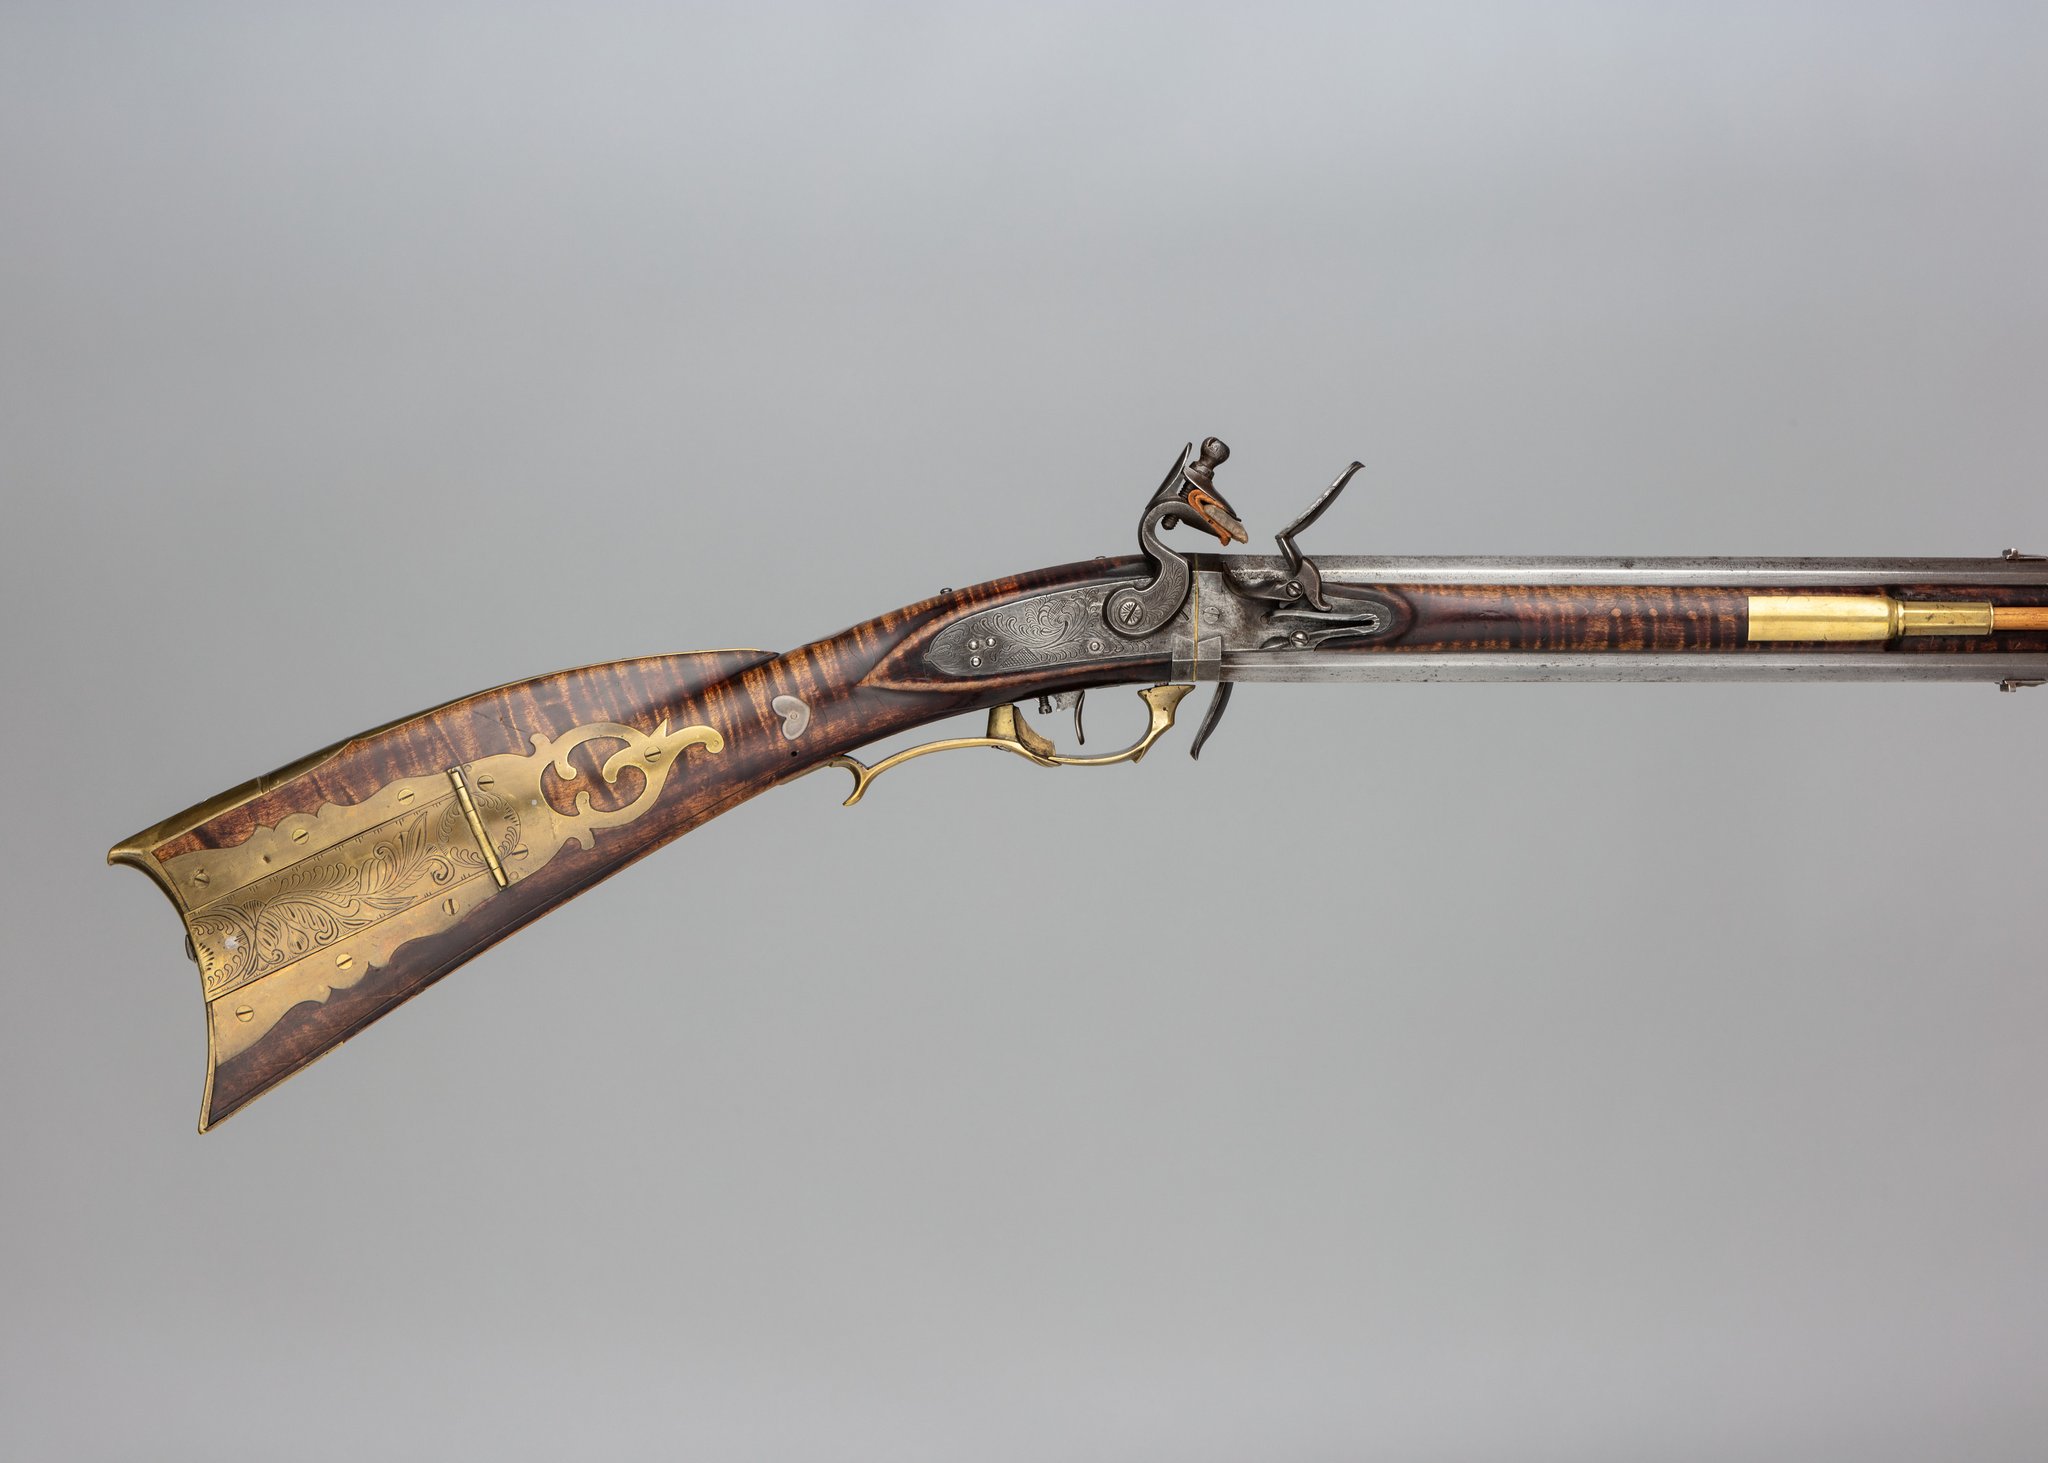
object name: swivel breech over under double barrel gun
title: Flintlock Swivel-Breech Longrifle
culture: american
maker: david boyer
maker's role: gunsmith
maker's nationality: american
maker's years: 1806-1883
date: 1830-1840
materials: brass, silver, steel, wood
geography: united states